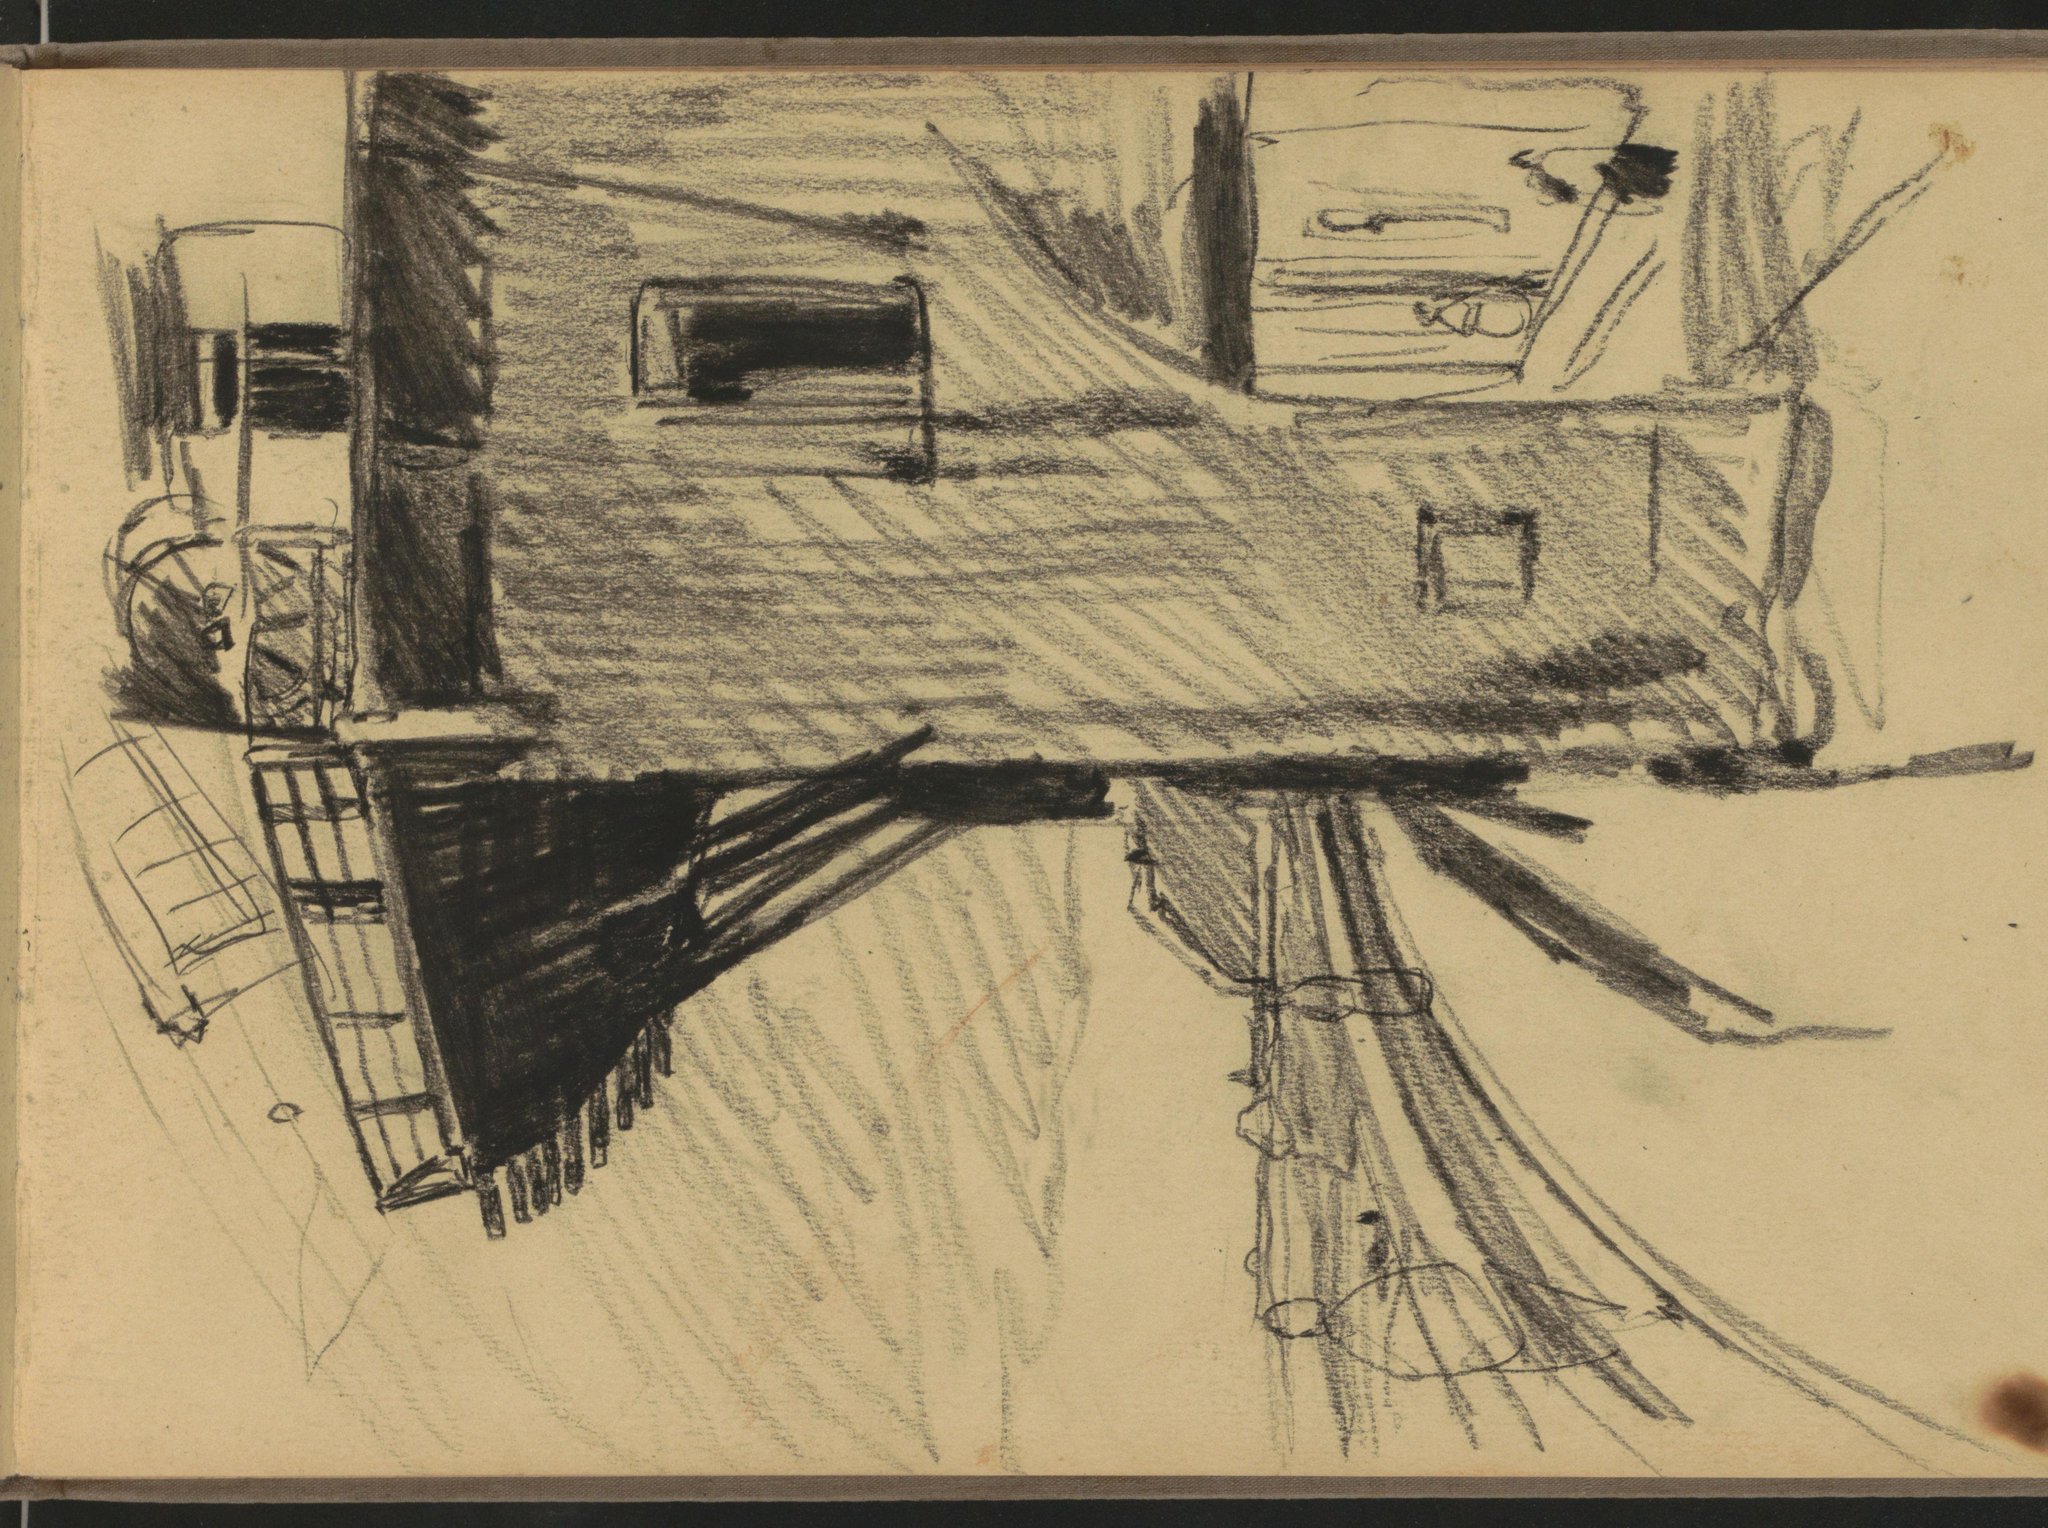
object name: sketchbook leaf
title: Gezicht op de poort van de molen Rijn en Lek te Wijk bij Duurstede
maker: willem witsen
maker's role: draughtsman, painter, print maker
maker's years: 1860-1923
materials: chalk, paper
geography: wijk bij duurstede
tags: windmill, street (+ city(-scape) with figures, staffage)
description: Voorstudie voor de ets 'Molenpoort, Wijk bij Duurstede', ca. 1908.